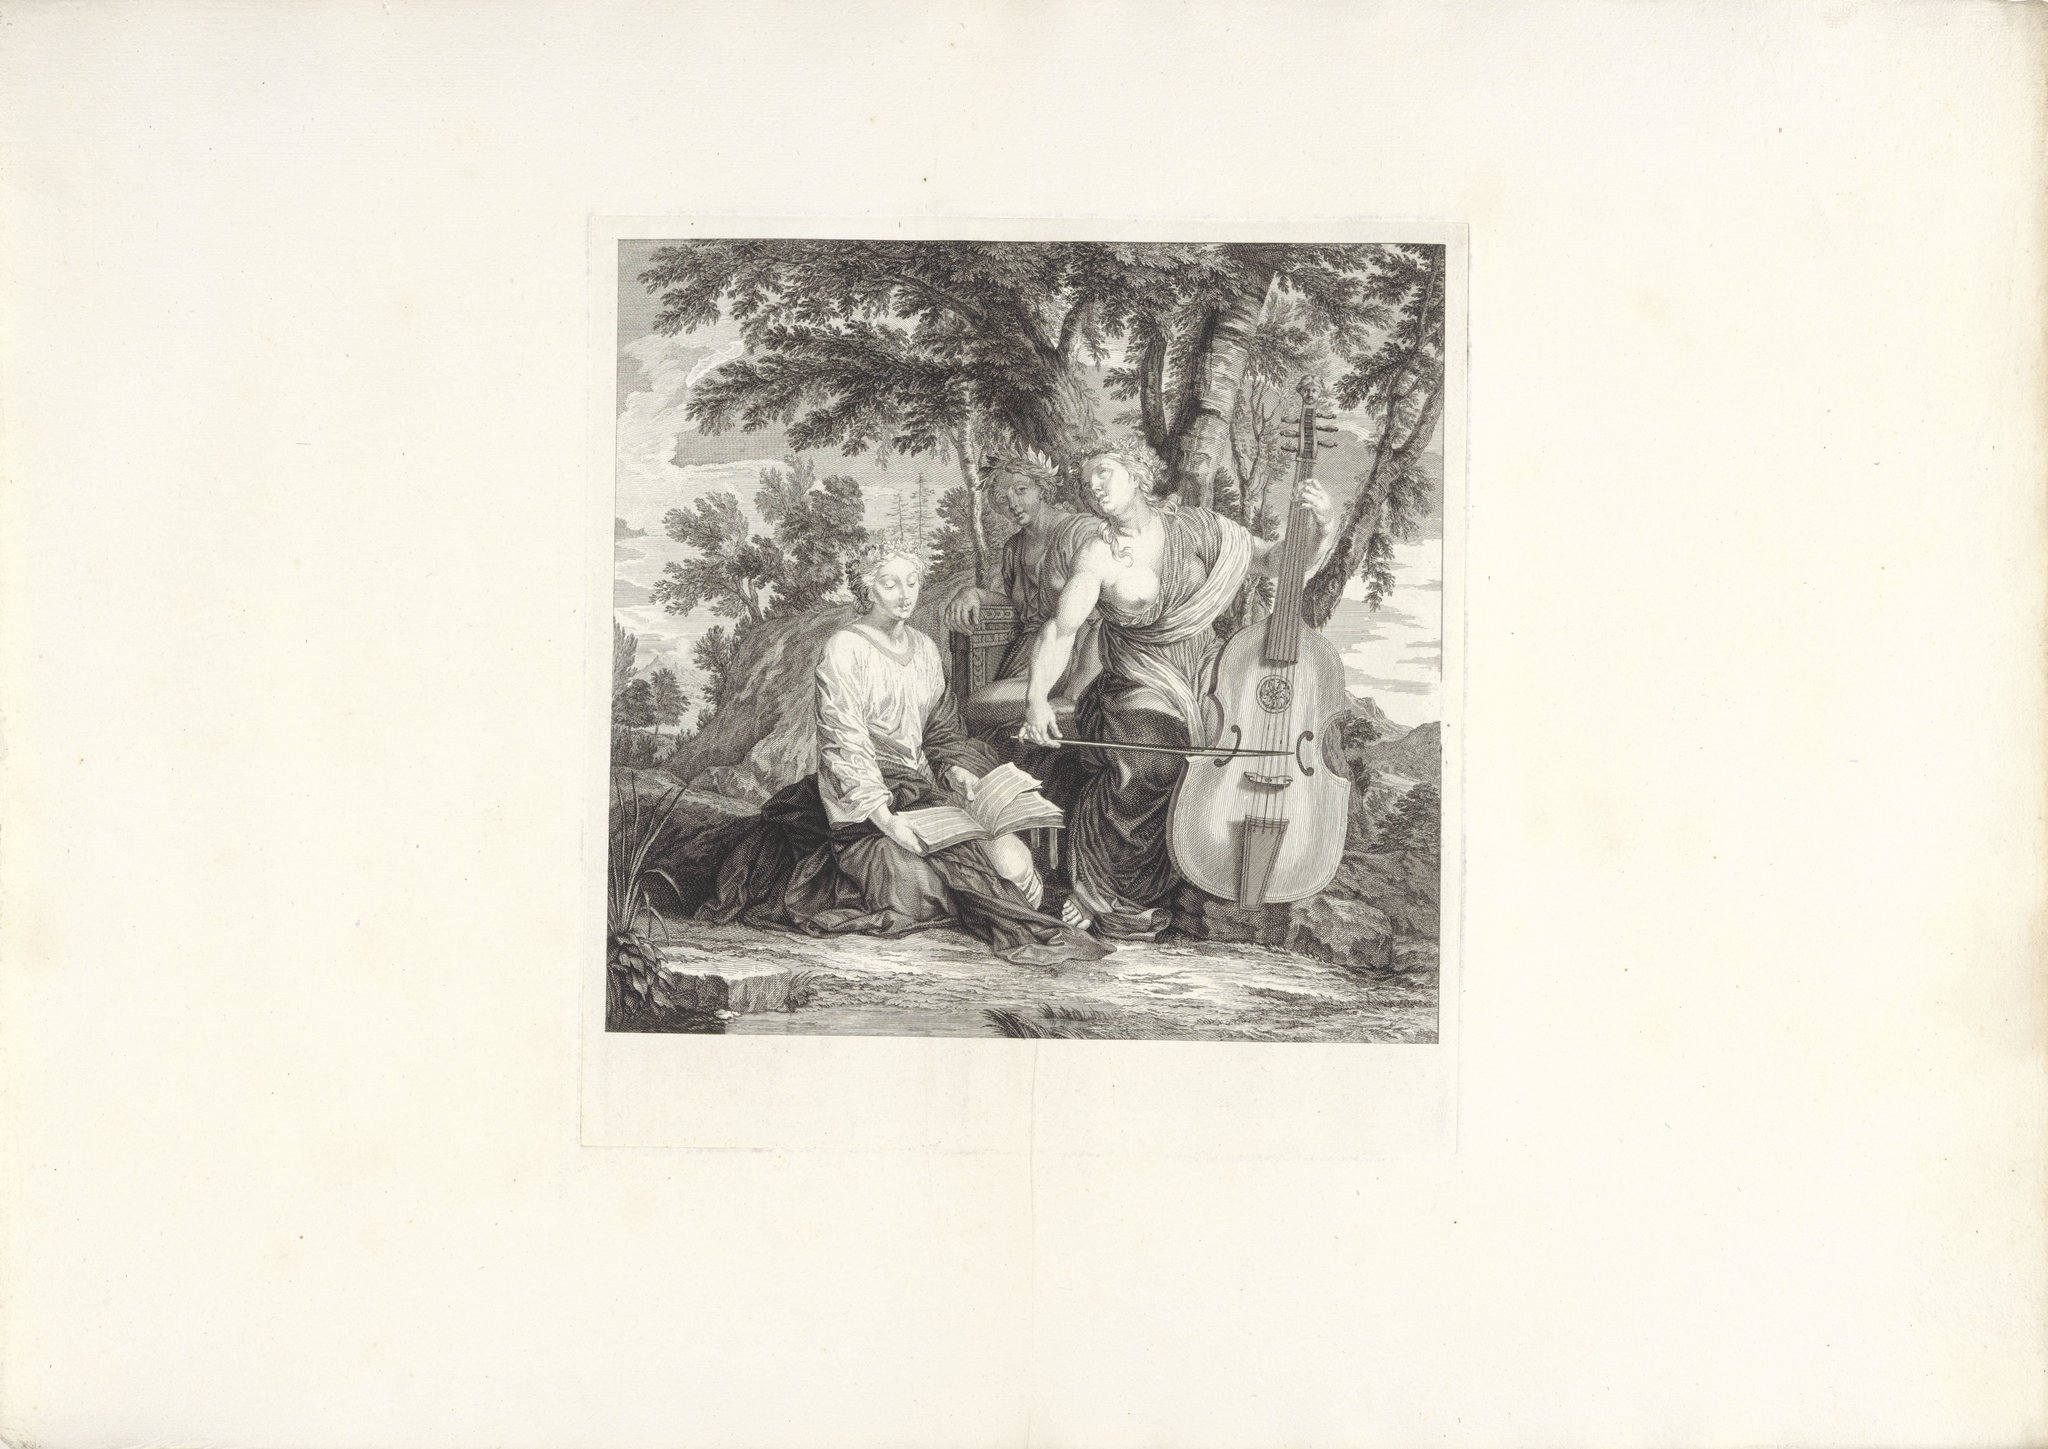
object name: print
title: Les peintures de Charles le Brun et d'Eustache Le Sueur qui sont dans (...) la maison du Président Lambert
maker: gaspard duchange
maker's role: print maker, publisher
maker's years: 1662-1757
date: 1740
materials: paper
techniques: engraving, etching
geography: paris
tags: erato (one of the muses); 'erato' (ripa), melpomene (one of the muses); 'melpomene' (ripa), polyhymnia (one of the muses); 'polinnia' (ripa)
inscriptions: collector's mark: Lugt 2228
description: Melpomene, de muze van het treurspel, Erato, de muze van lyriek en liefdespoëzie, en Polyhymnia, de muze van de hymnen, musiceren samen onder een boom. Naar het schilderij dat hing in de Chambre des Muses van het Hôtel Lambert. Prent maakt deel uit van een serie prenten naar de schilderijen in het Hôtel Lambert te Parijs.